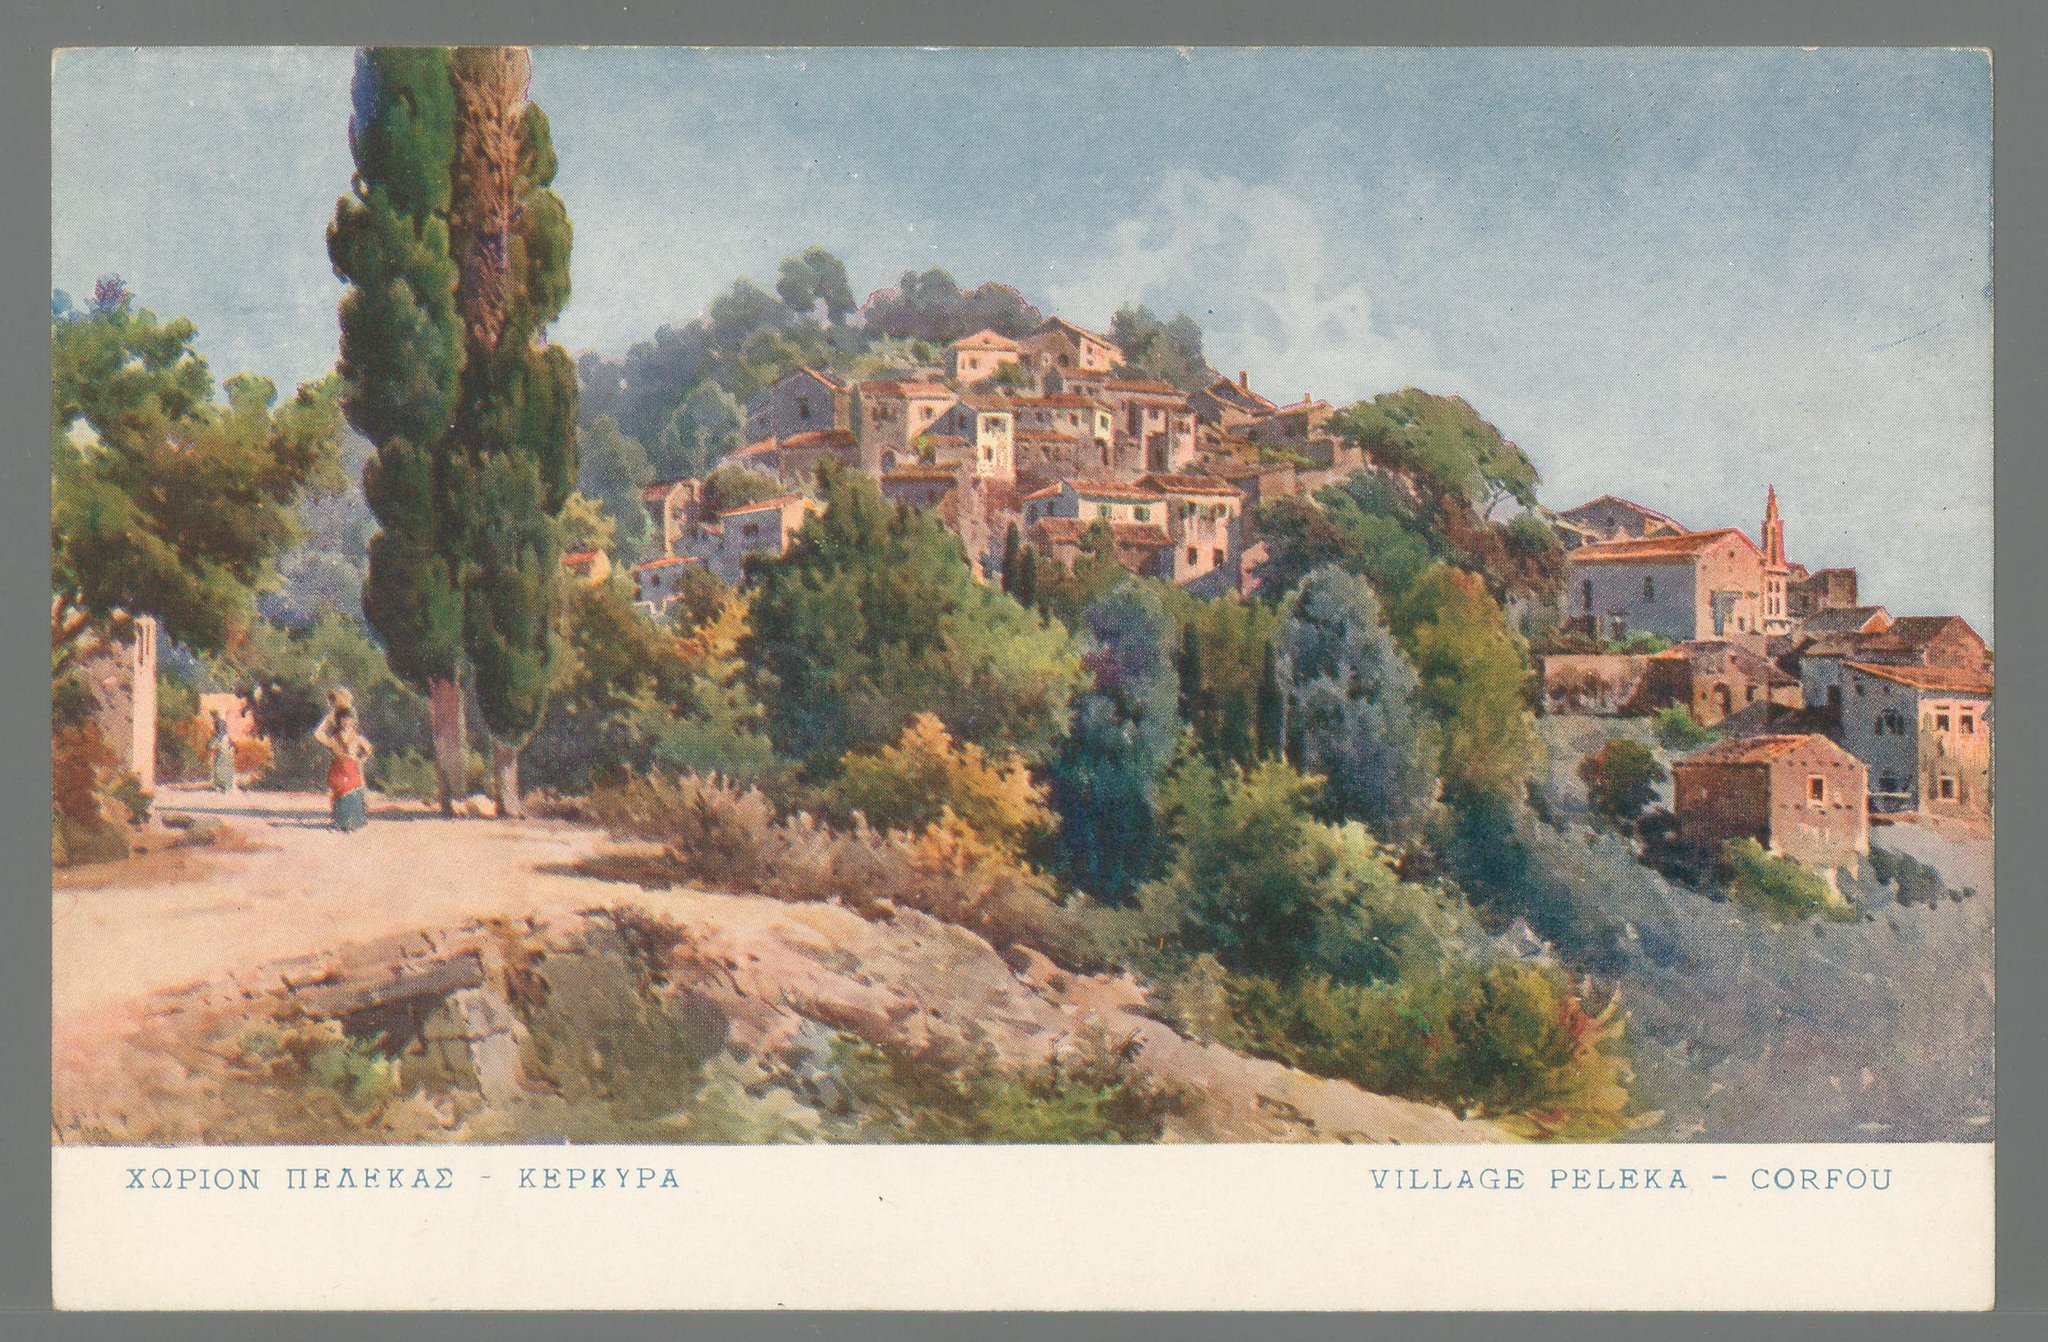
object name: photomechanical print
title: Village Peleka - Corfou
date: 1906-1909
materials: cardboard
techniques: writing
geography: corfu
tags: village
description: Voor de Franse titel staat de titel in het Grieks.